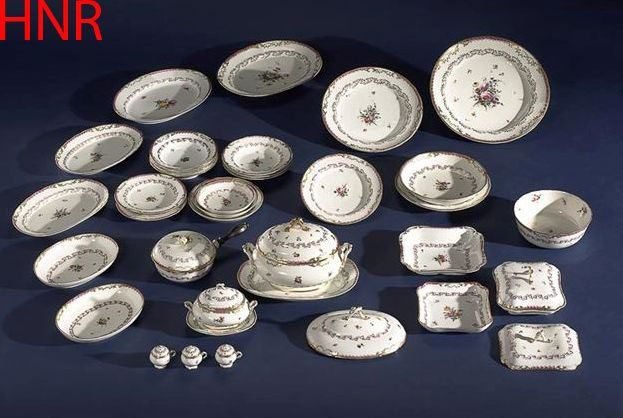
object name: tureen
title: Terrine met twee oren en deksel,behorend bij een servies met geslingerd lintmotief met bladertakken, bloemboeketten en gestrooide bloemtakken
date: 1780-1820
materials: porcelain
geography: loosdrecht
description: Terrine met twee oren en deksel, behorend bij een servies van porselein, versierd met een geslingerd lintmotief in paars en goud met groene bladertakken, bloemboeketten en gestrooide bloemtakken. Randen lichtgegolfd met decoratie in goud met paars bladmotief waartussen groen gekruist bladmotief. Gemerkt: M.O.L. en Amstel. Opmerking: stukje in voet terrine gelijmd.